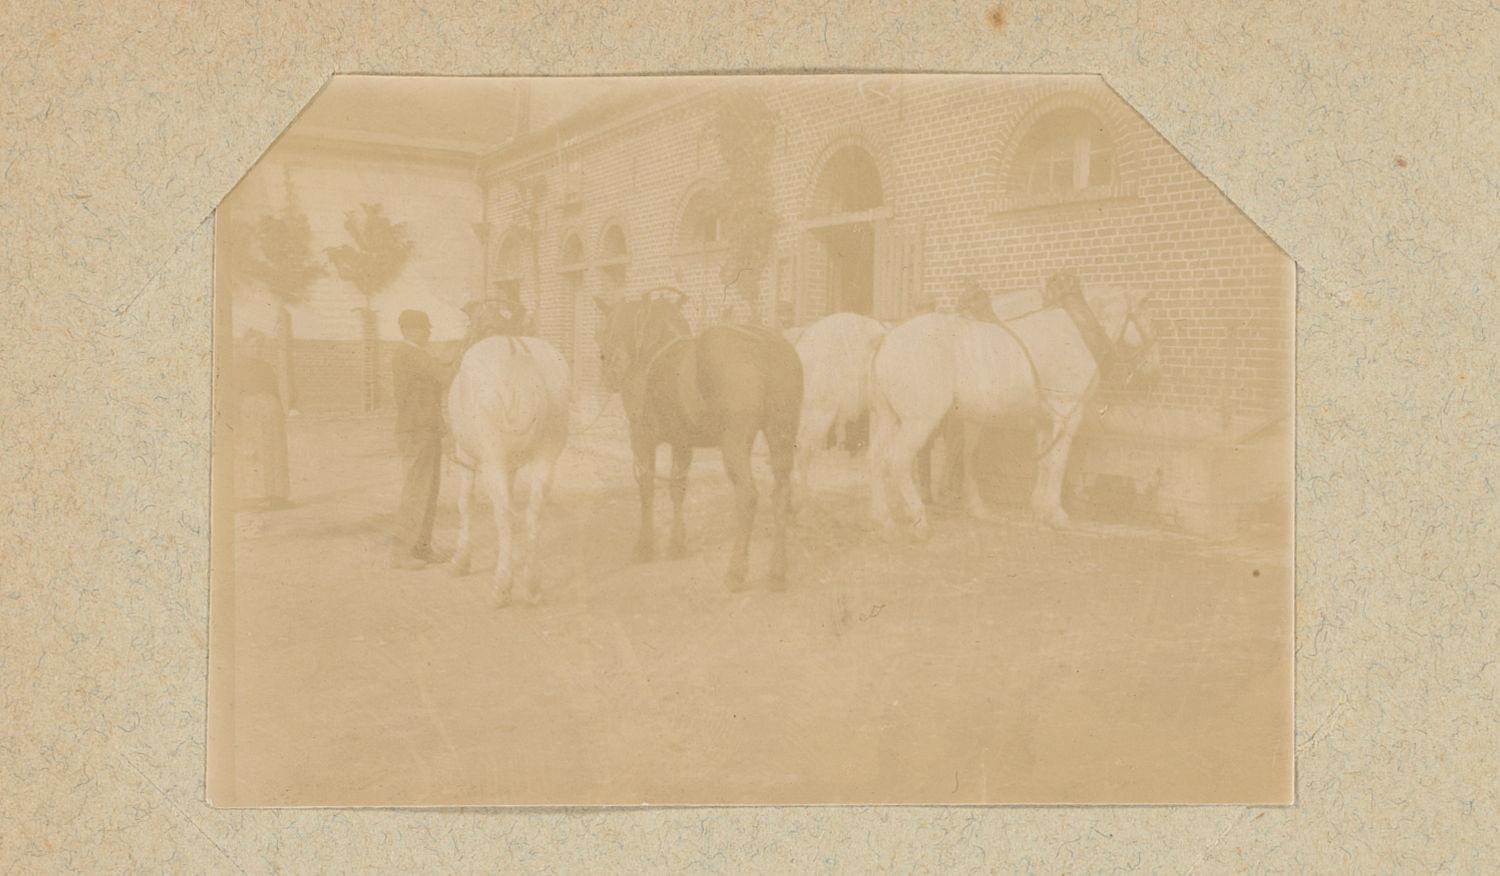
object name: album leaf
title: Vier paarden en een man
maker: Anonymous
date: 1897-1900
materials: paper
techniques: gelatin silver print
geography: france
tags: adult man, horse, france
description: Over de foto is een ander negatief afgedrukt van een voorstelling van bomen.